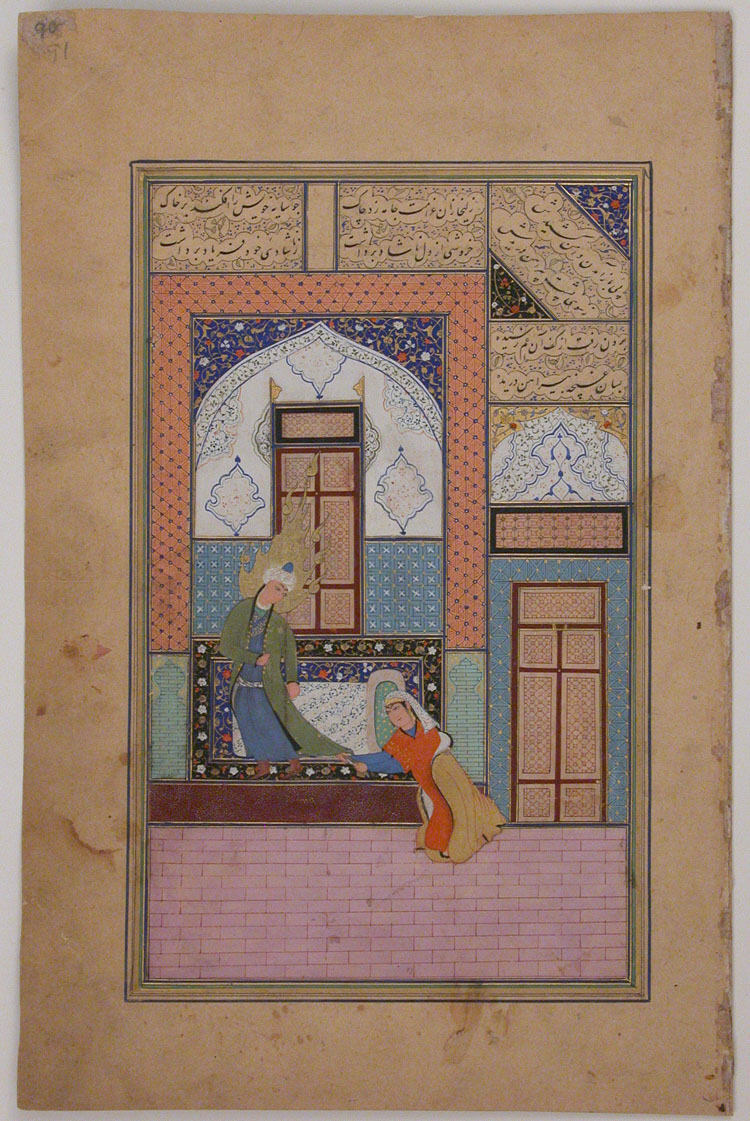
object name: folio from an illustrated manuscript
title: "Zulaikha Seizing the Skirt of Joseph's Robe", Folio of a Yusuf and Zulaykha of Jami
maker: maulana nur al-din `abd al-rahman jami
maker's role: author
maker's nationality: iranian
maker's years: 1414-1492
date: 1523-1524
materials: gold, ink, paper, watercolor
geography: uzbekistan